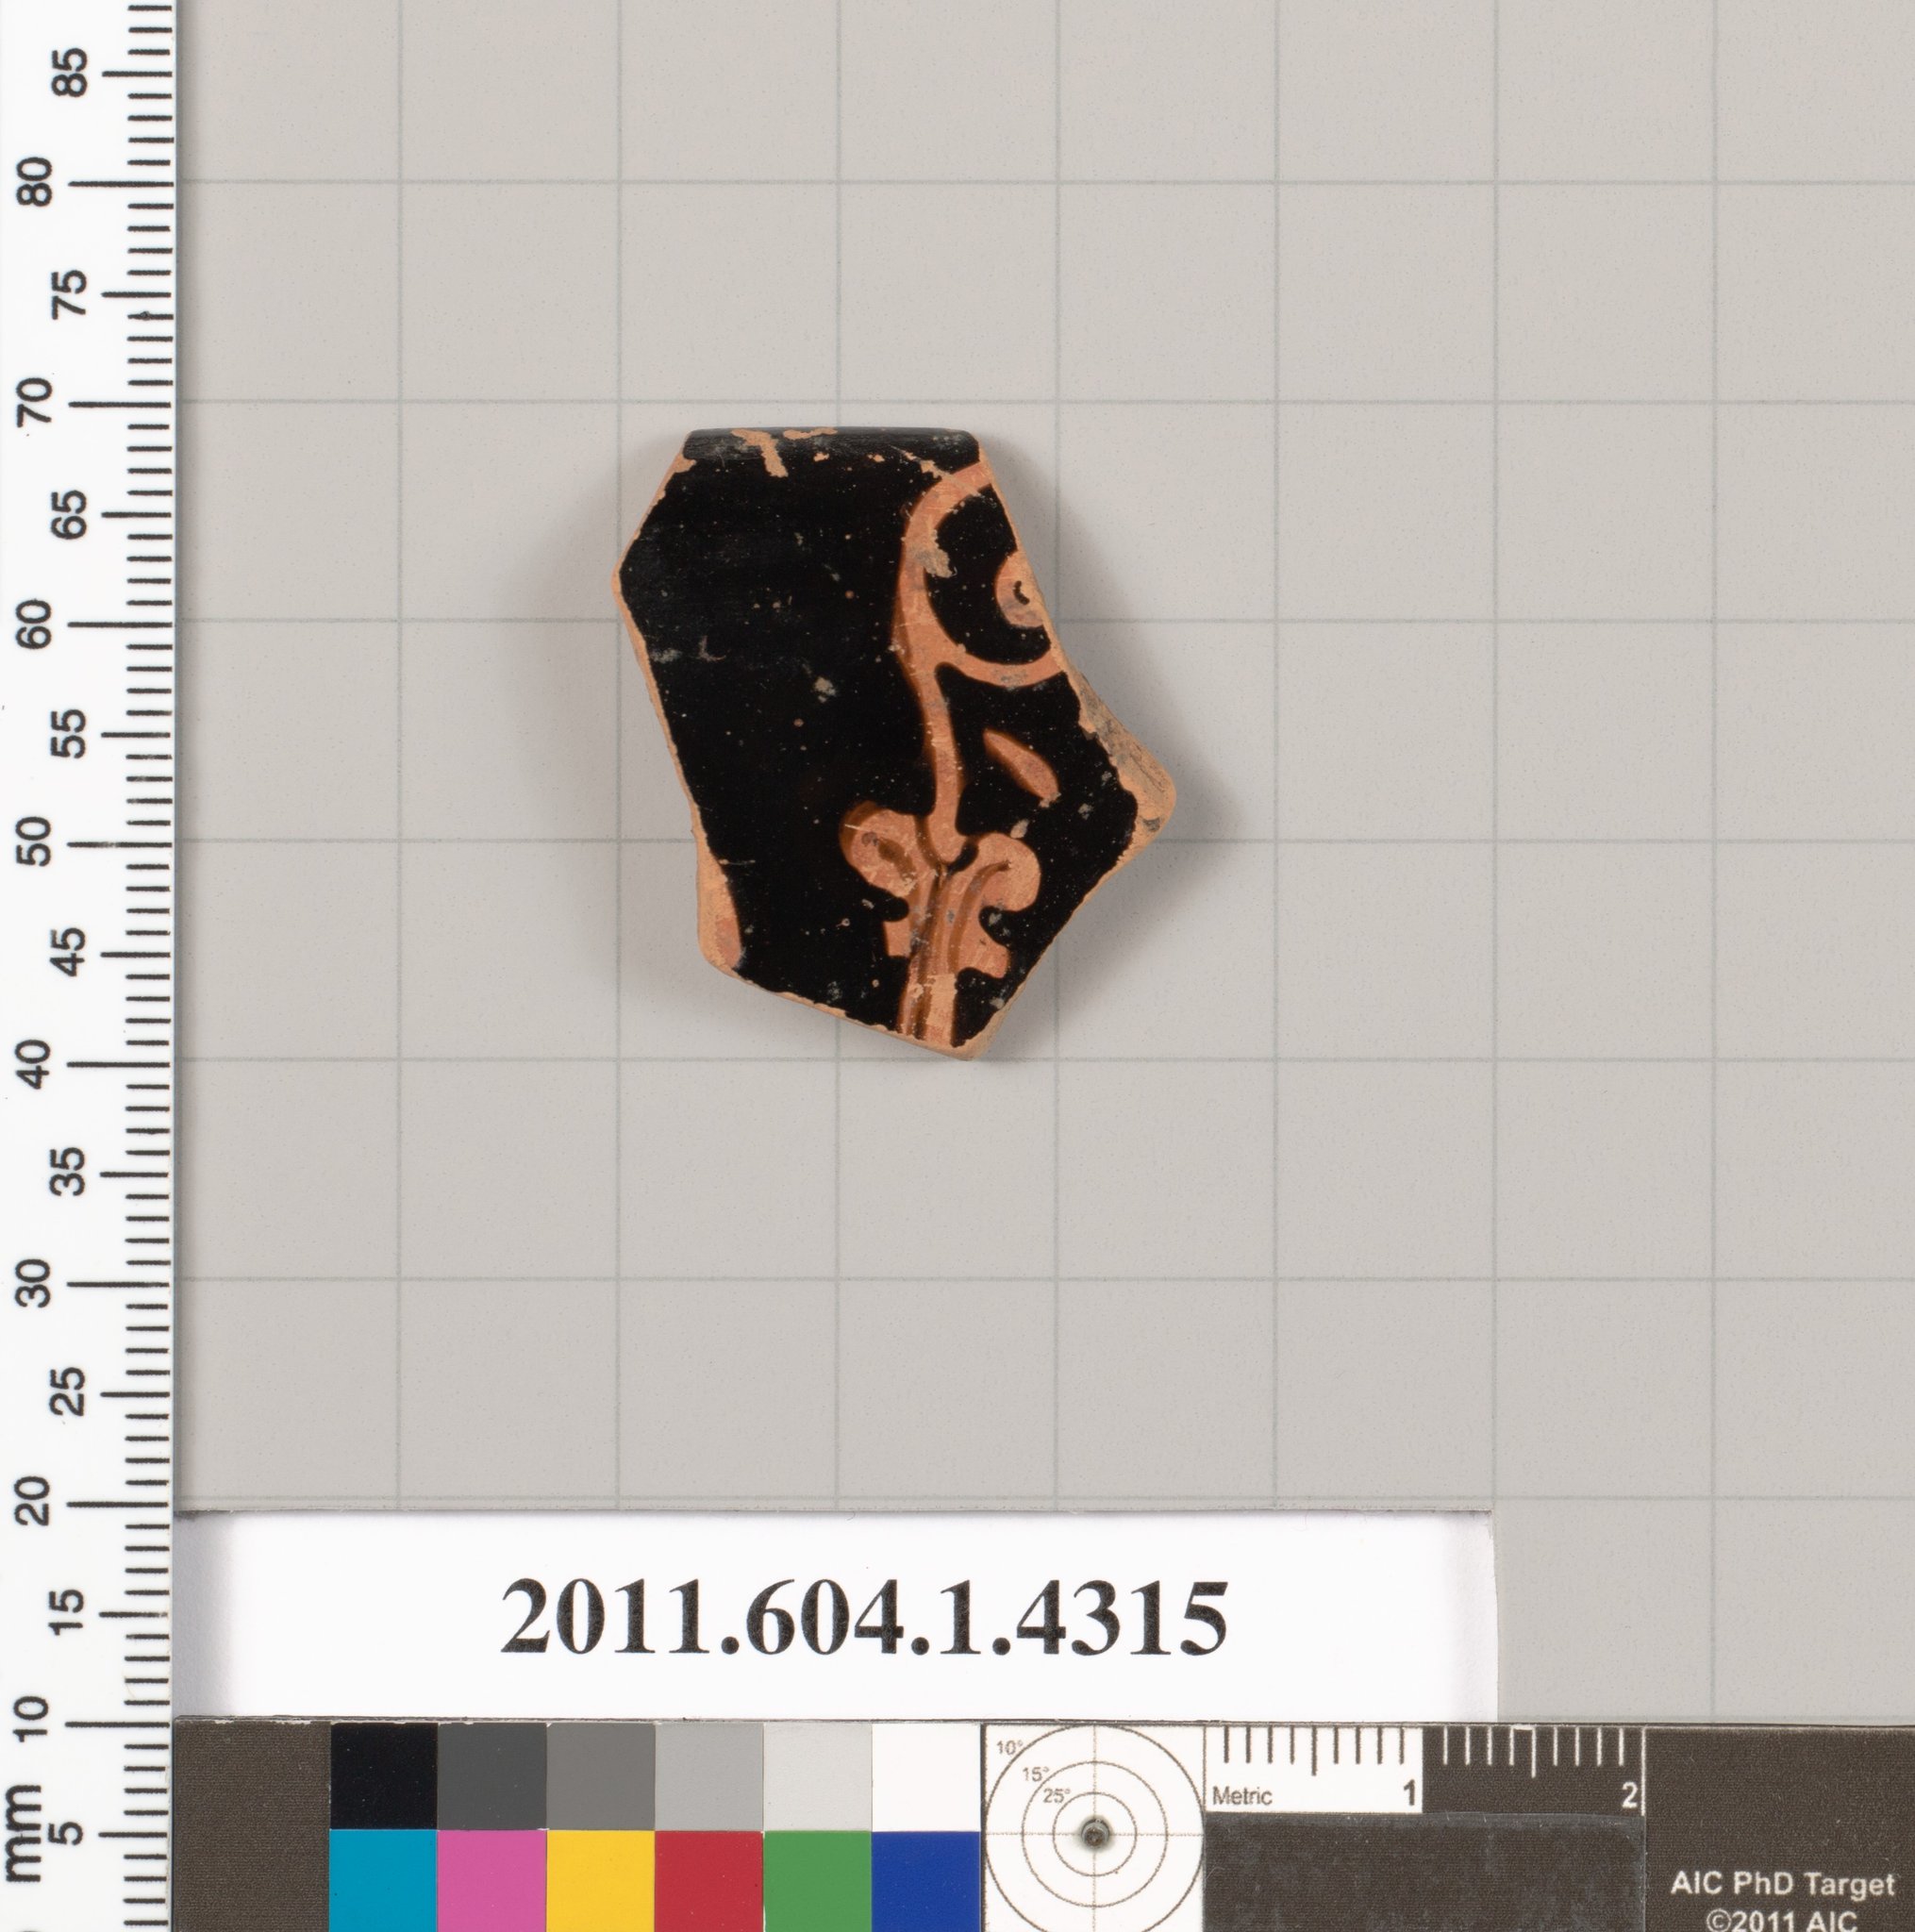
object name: kylix fragment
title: Terracotta rim fragment of a kylix (drinking cup)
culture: greek, attic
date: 500-451 BCE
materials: terracotta